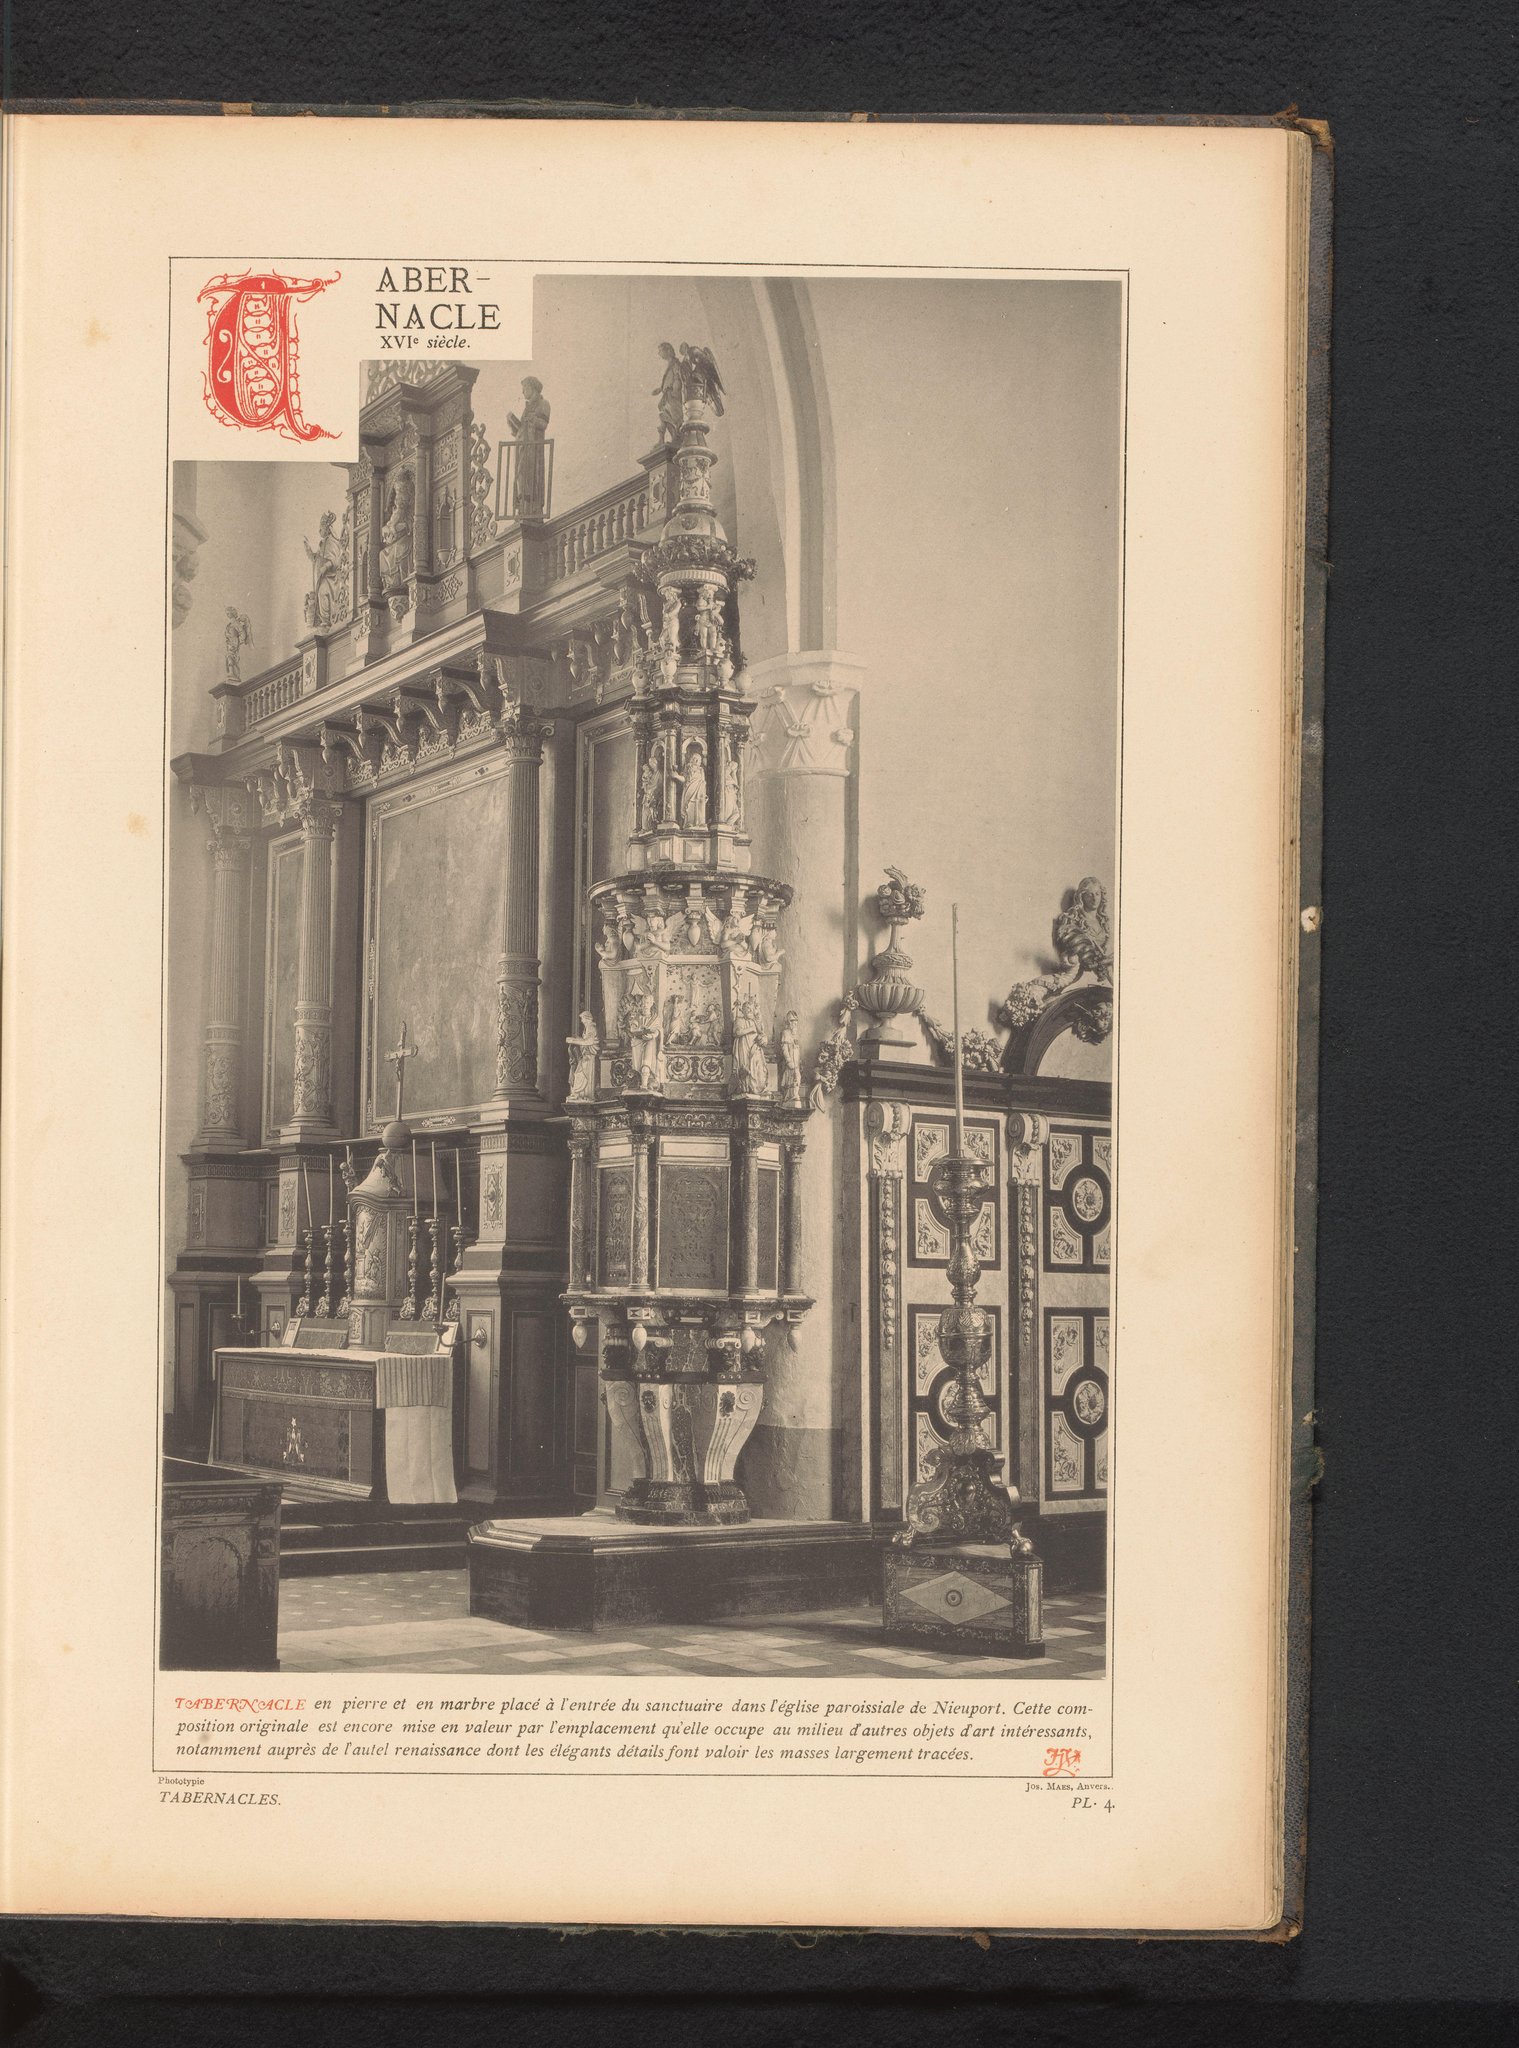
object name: page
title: Tabernacle, XVIe siècle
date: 1882-1887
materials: paper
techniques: photograph, photolithography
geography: church of our lady nieuwpoort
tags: tabernacle ~ altar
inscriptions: inscription: ‘TABERNACLE en pierre (...)’, inscription: ‘TABERNACLES. - PL. 4.’, monogram: ‘JJvY’